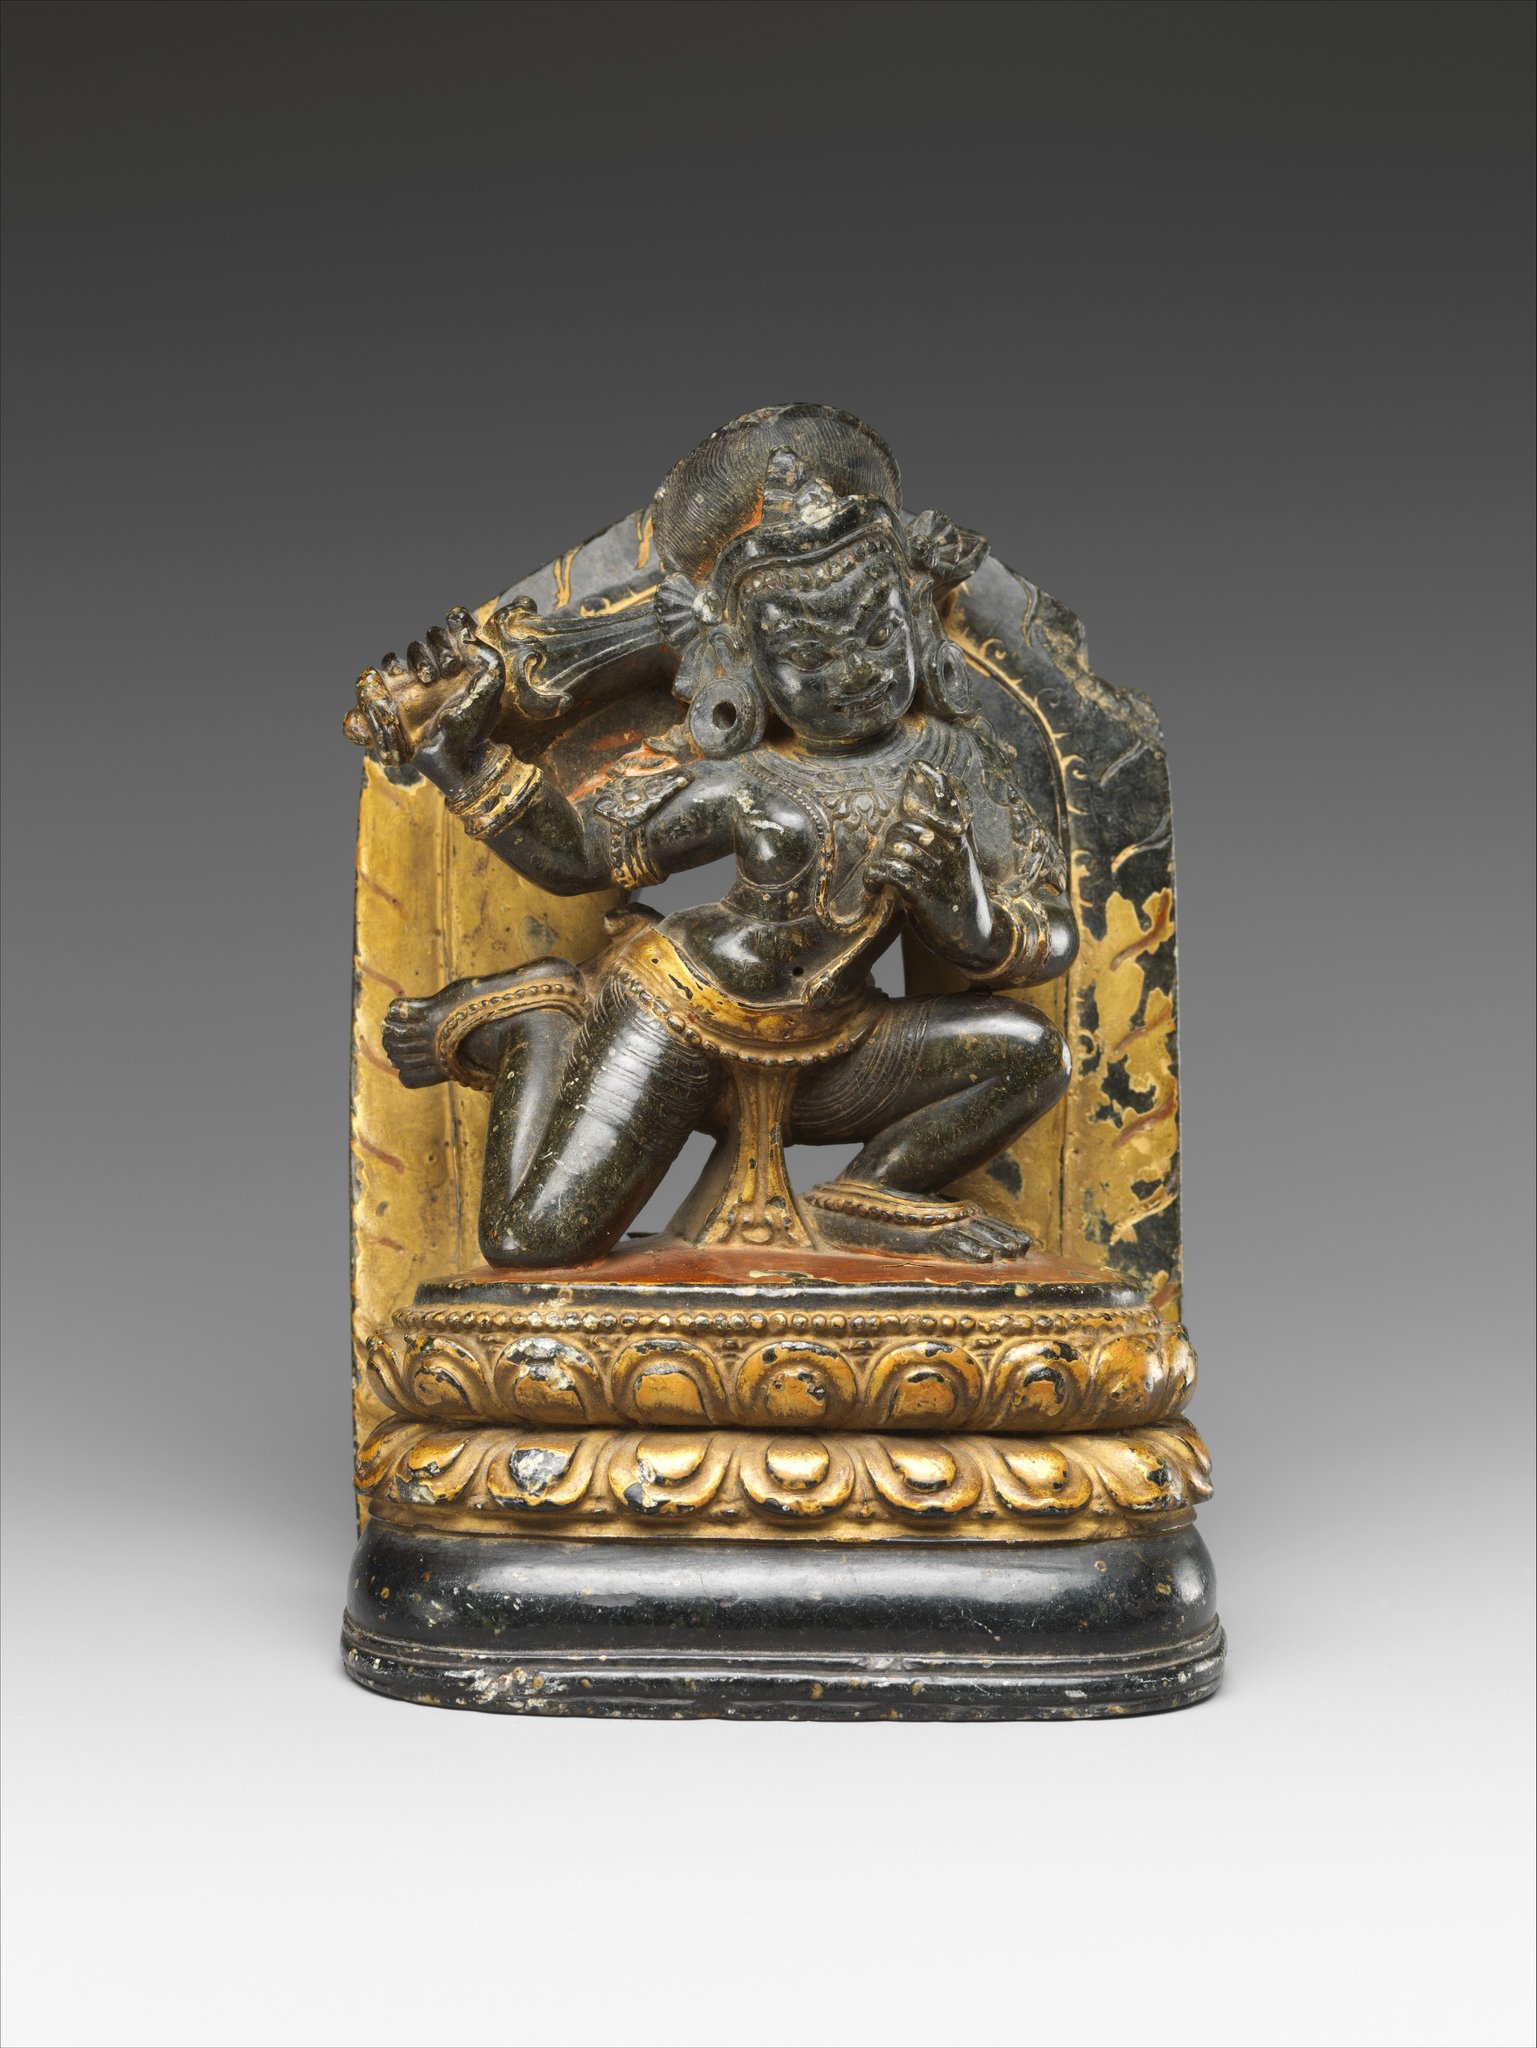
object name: stele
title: Acala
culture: tibetan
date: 1101-1200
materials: stone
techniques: gilding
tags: buddhism,deities